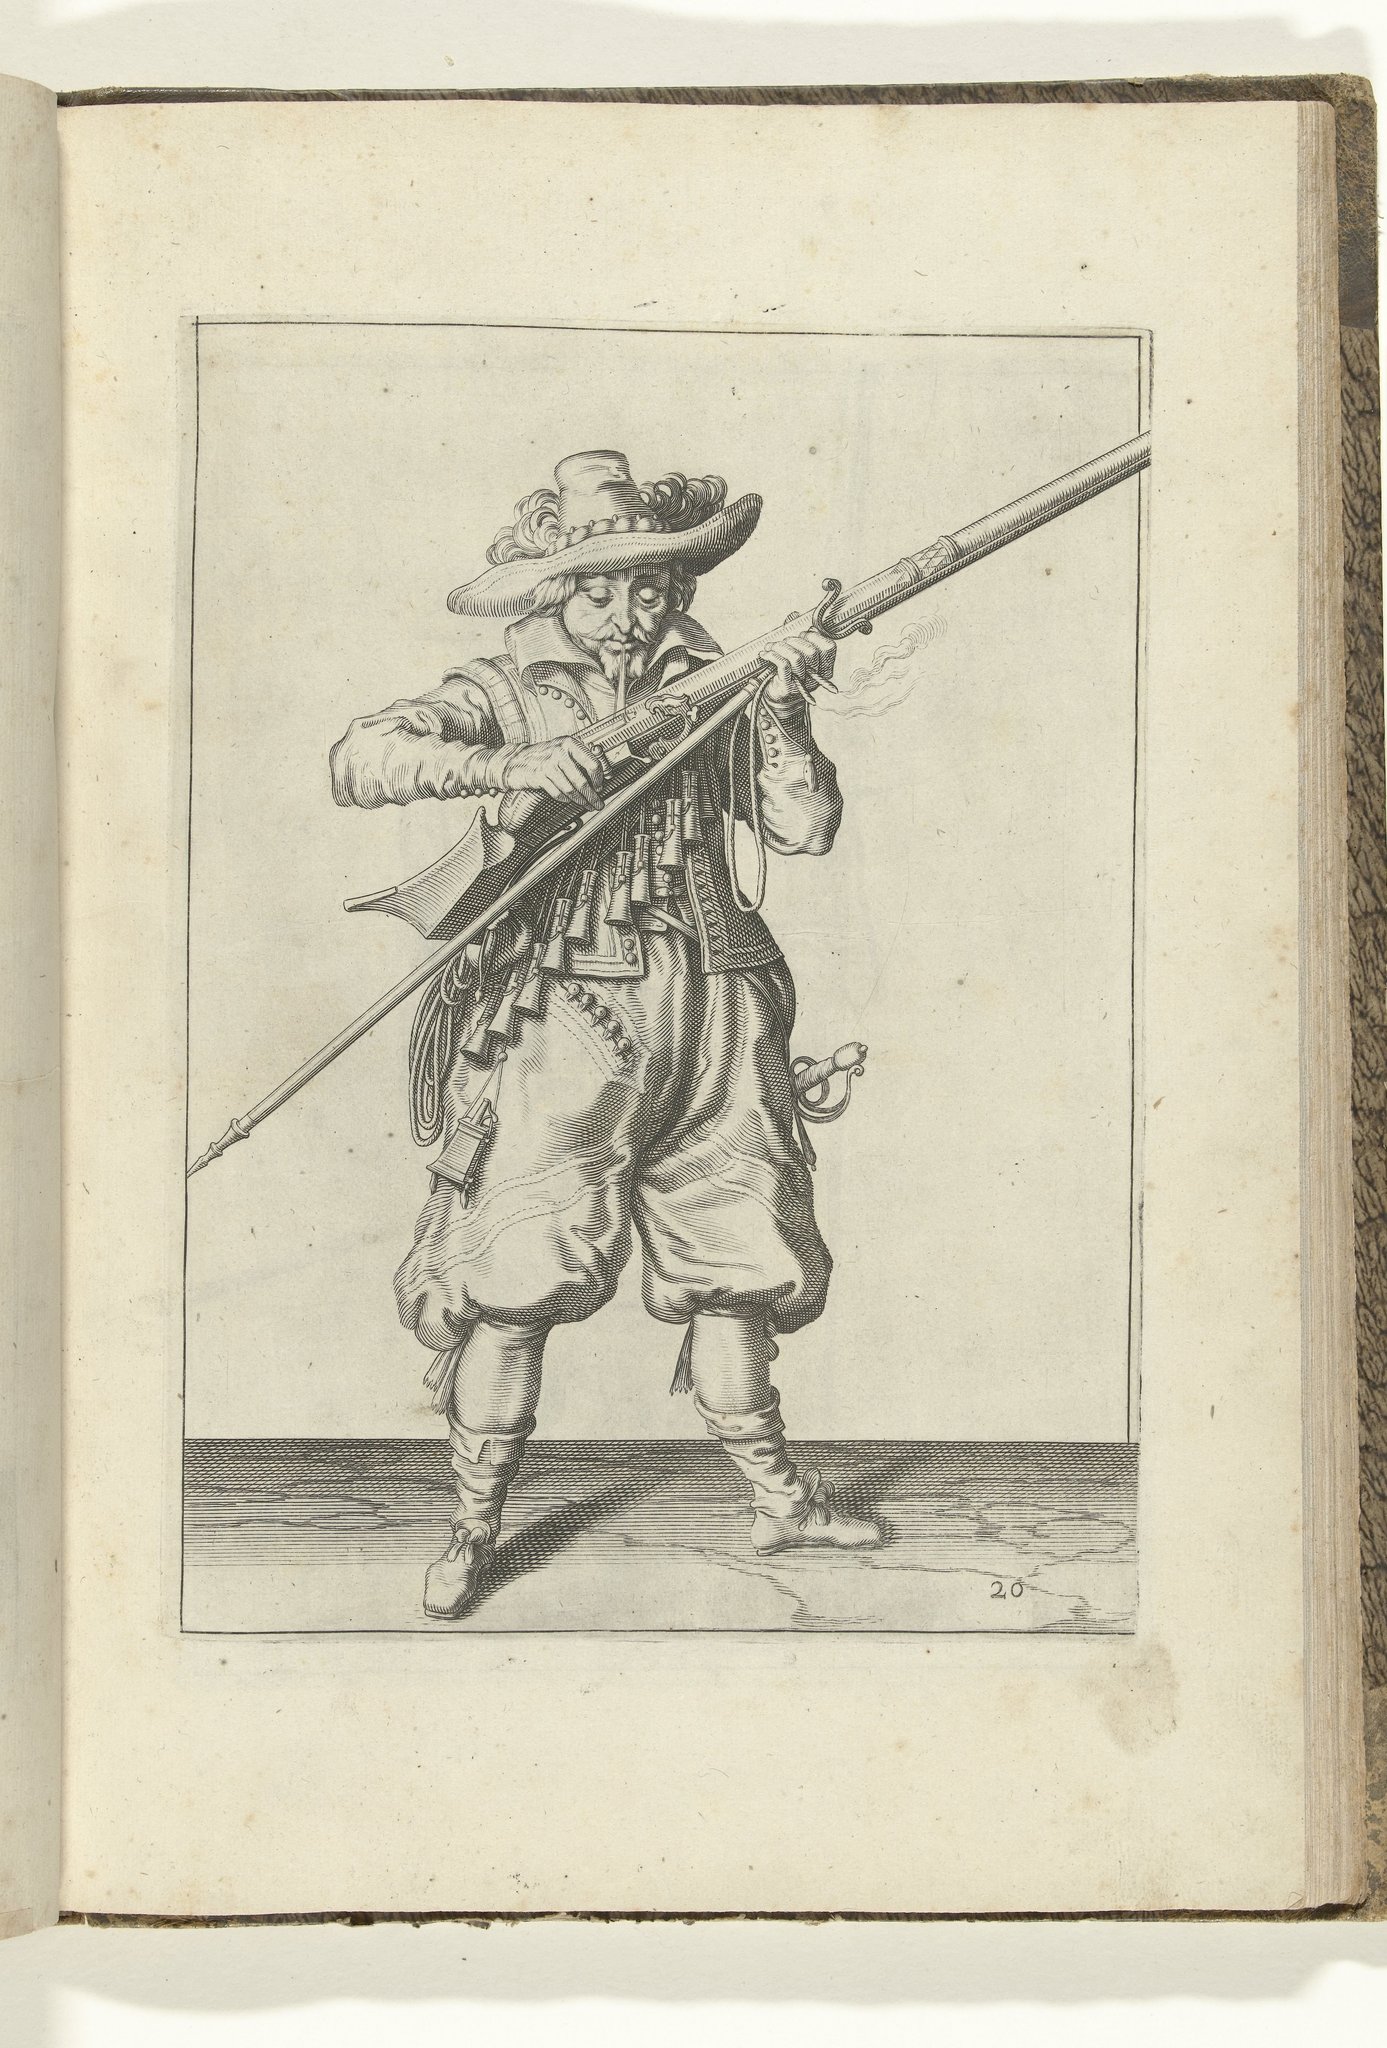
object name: print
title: Soldaat die kruit van zijn musket blaast (nr. 20), ca. 1600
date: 1597-1608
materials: paper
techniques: engraving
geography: northern netherlands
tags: the hague, maurice (prince of orange), handling of weapons ~ military training, weapons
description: Een soldaat, ten voeten uit, die met beide handen een musket (een bepaald type vuurwapen) bij zijn mond houdt en erover blaast, om eventueel buiten de pan (het kruitreservoir) gevallen kruit ervan af te krijgen (nr. 20), ca. 1600. In zijn linkerhand behalve de loop van het musket ook een furket (musketvork) en een brandende lont. Plaat 20 in de instructies voor het hanteren van het musket: Brief enseignement, sur les pourtraitz figurez, touchant le droit maniement du Mousquet. Onderdeel van de illustraties in een Franse editie van J. de Gheyns Wapenhandelinghe: J. de Gheyn, Maniement d'armes, d'arquebuses, mousquetz et piques : en conformité de l'ordre de Mour le Prince Maurice, Prince d'Orange, Amsterdam 1608. Krijgswezen rond 1600.